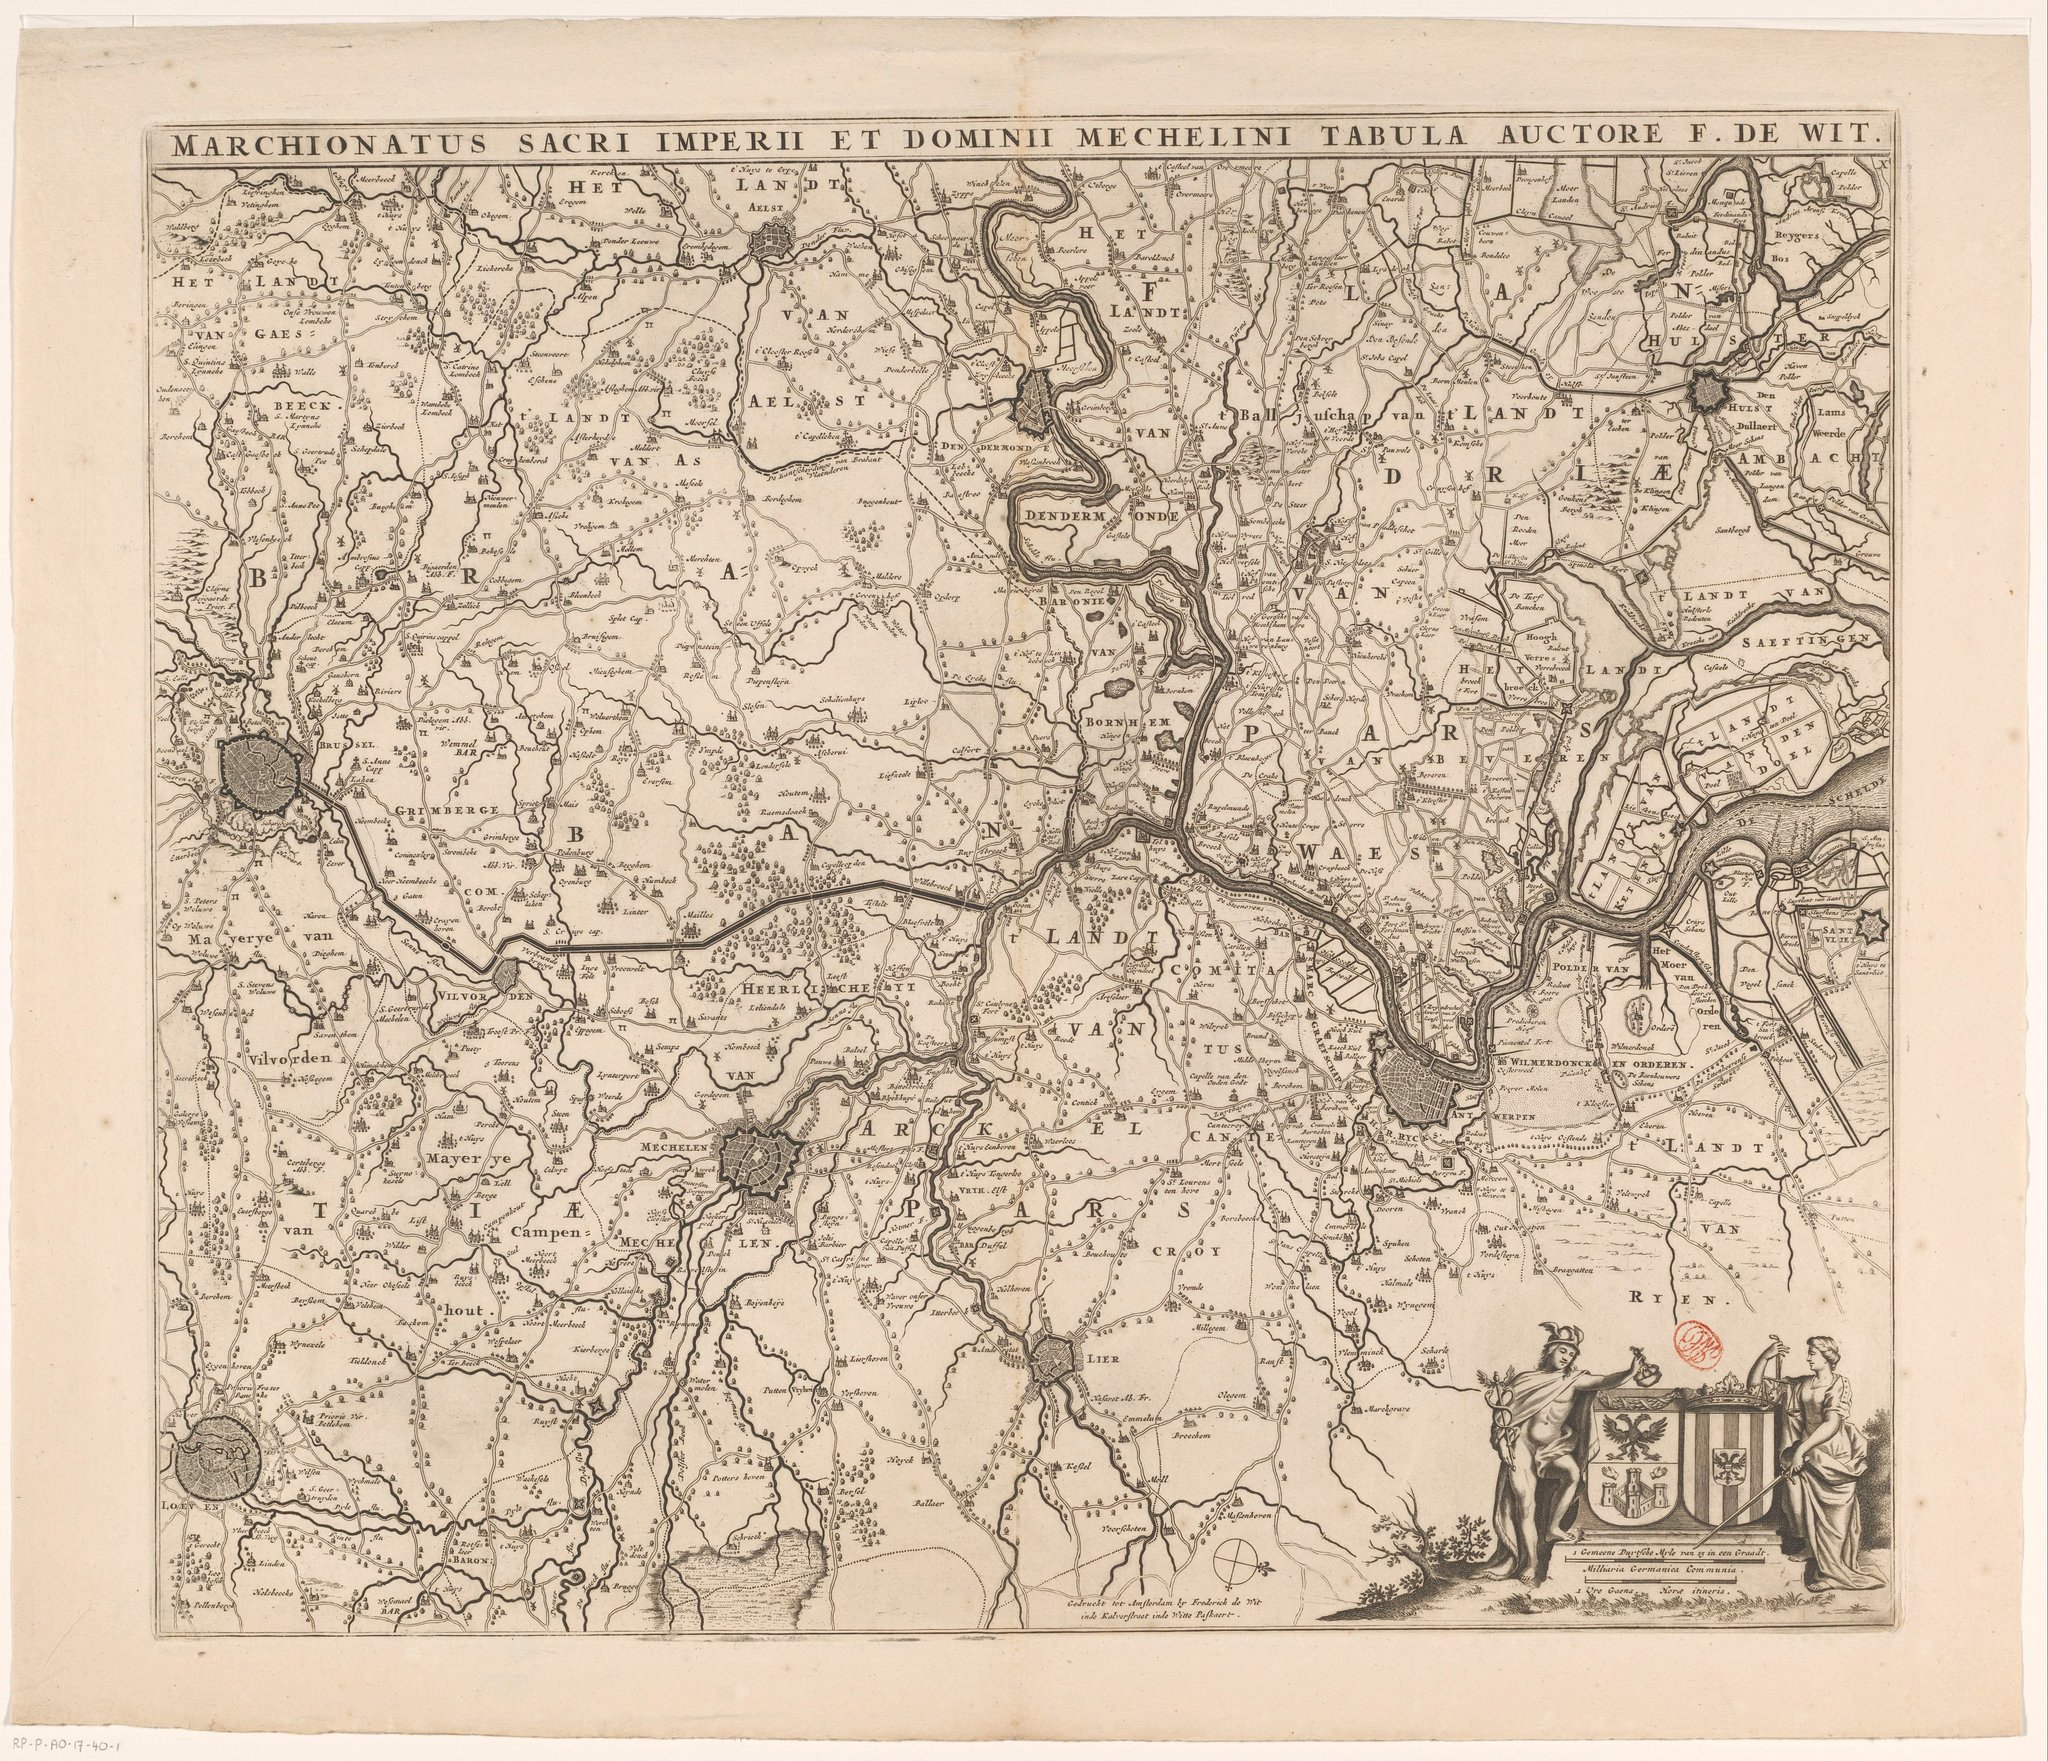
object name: print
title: Marchionatus Sacri Imperii et dominii Mechelini tabula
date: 1666-1667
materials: paper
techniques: engraving, etching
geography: amsterdam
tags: coat of arms (as symbol of the state, etc.) (+ city; municipal), maps of separate countries or regions, (story of) mercury (hermes), justitia (justice) as roman personification, coat of arms (as symbol of the state, etc.) (+ province; provincial), antwerp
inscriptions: collector's mark: Lugt 195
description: Kaart van een deel van Vlaanderen, het gebied rond Antwerpen en Mechelen. In een balk boven de kaart de titel. Rechtsonder de wapens van Antwerpen en Mechelen met daarnaast Mercurius en Justitia. Onder de wapens twee schaalstokken: 1 Gemeene Duytsche Myle van 15 in een Graadt / 1 Ure Gaens.